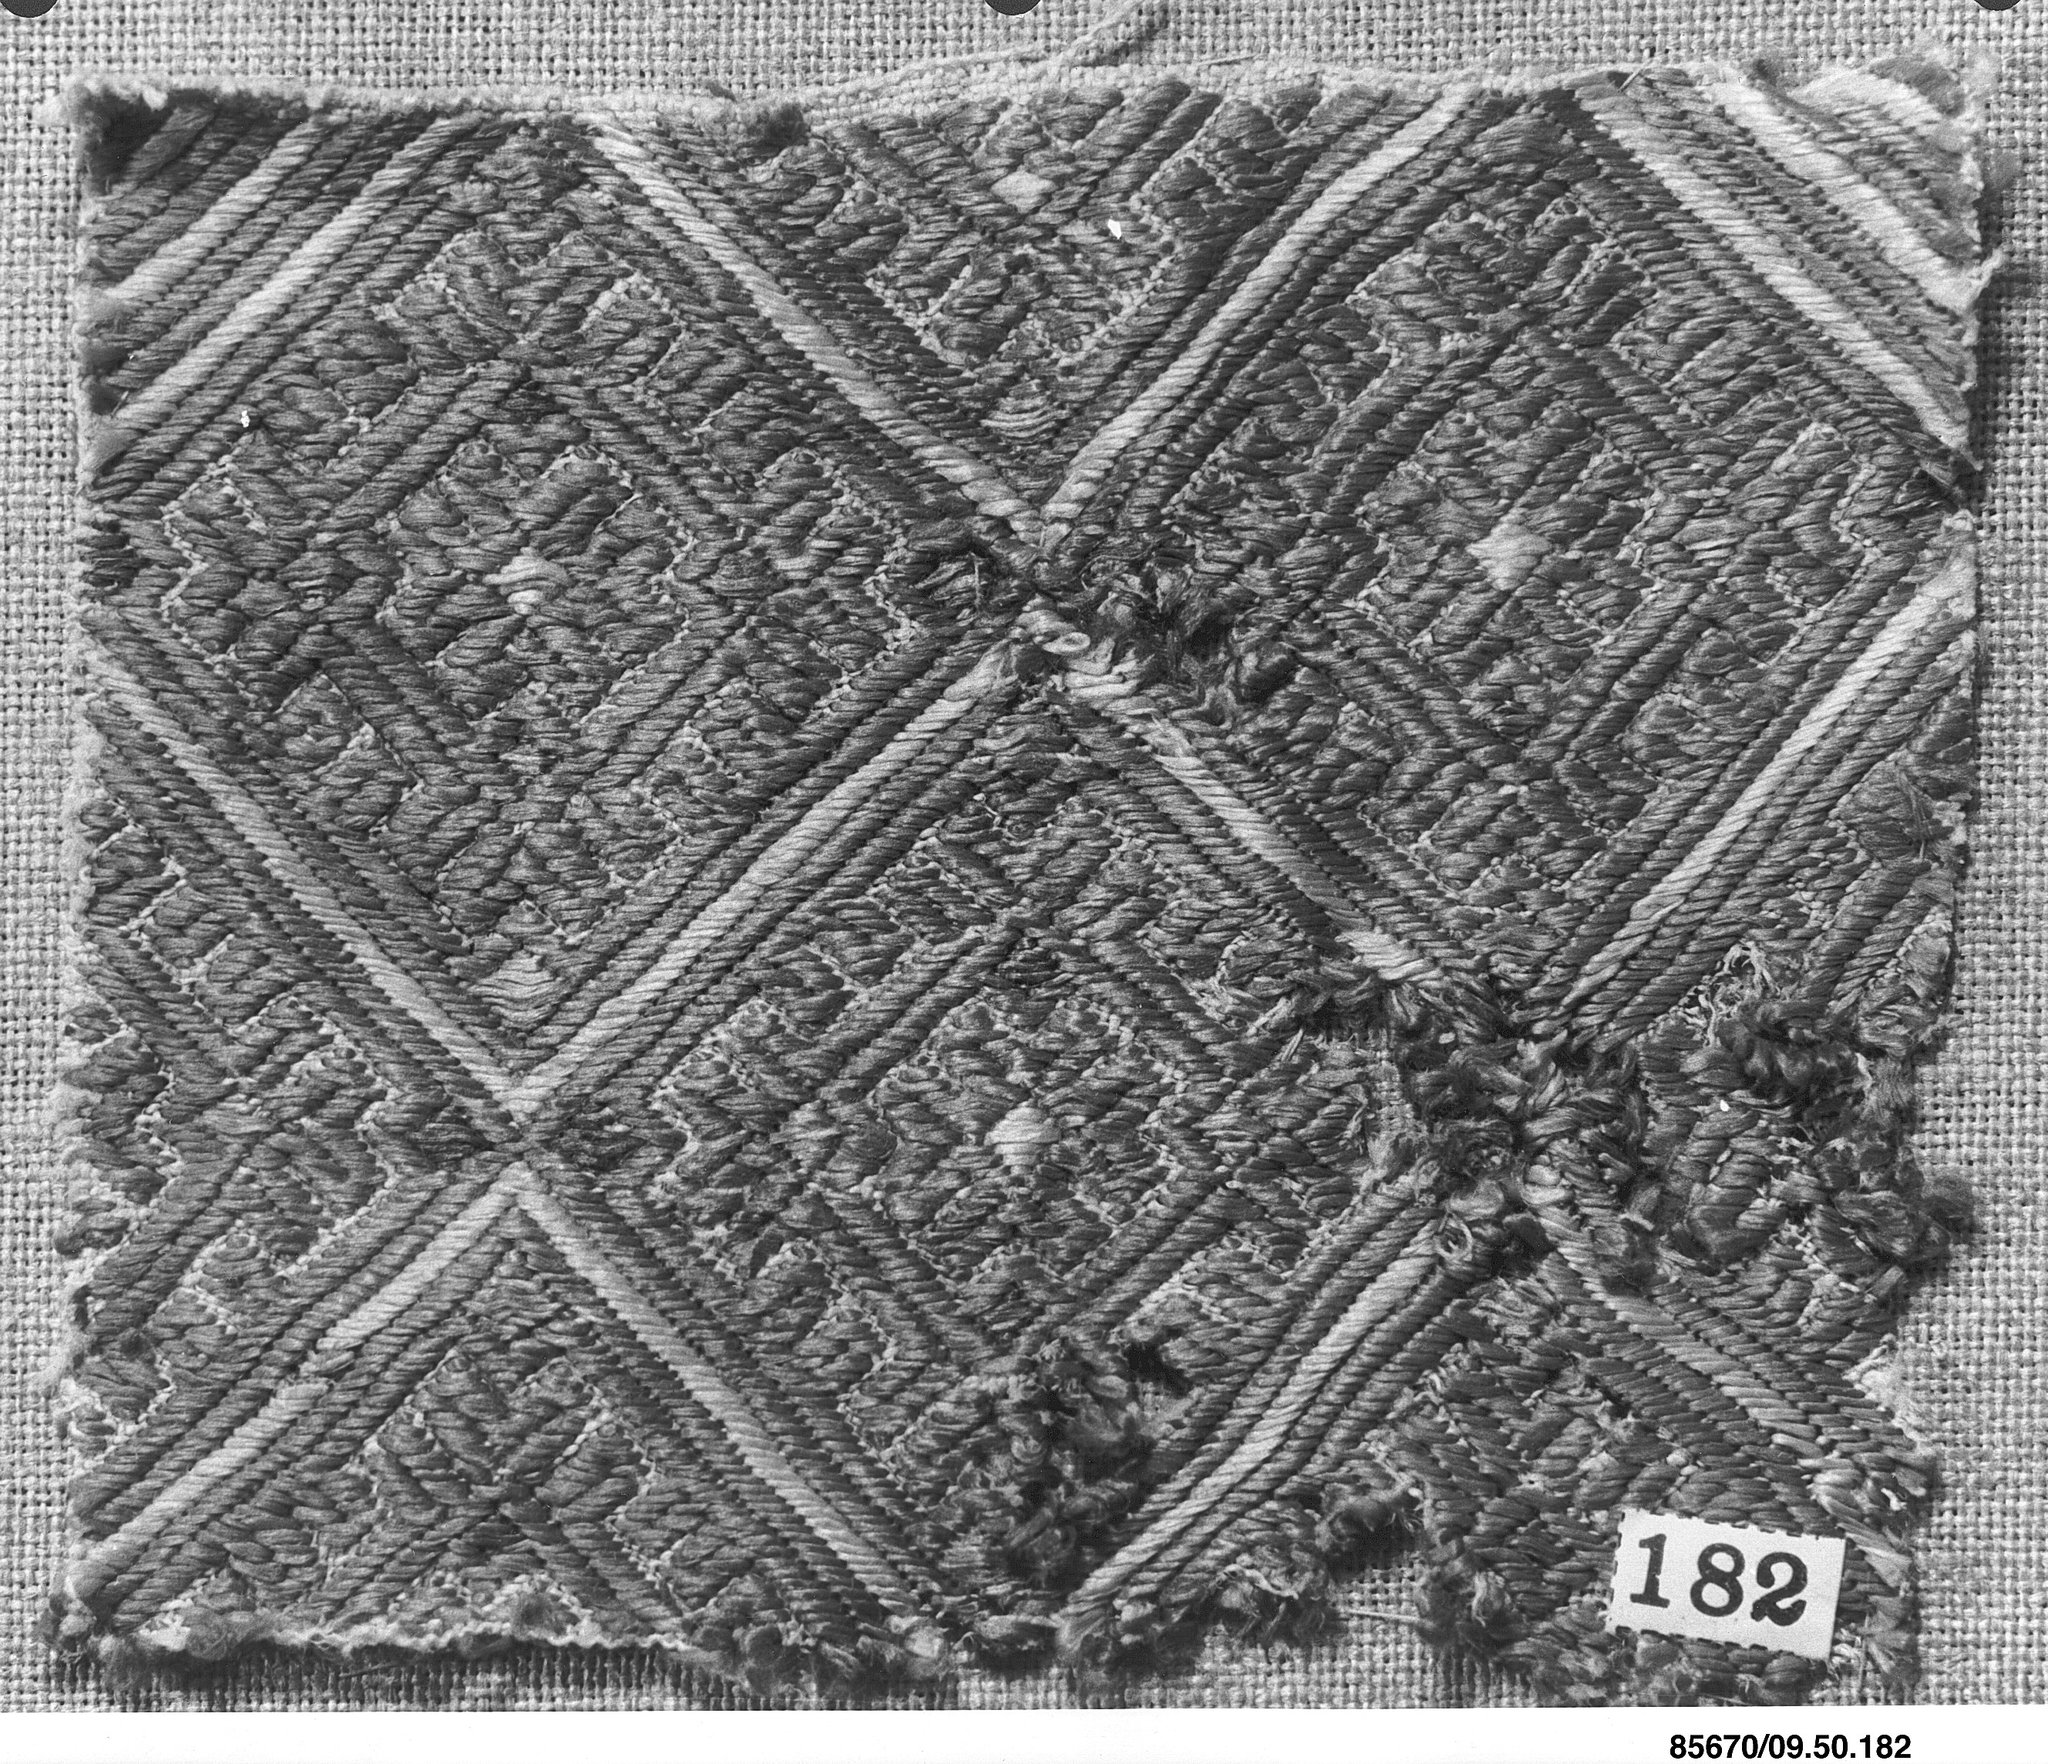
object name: costume fragment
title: Peasant costume fragment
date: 1701-1900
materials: canvas, silk